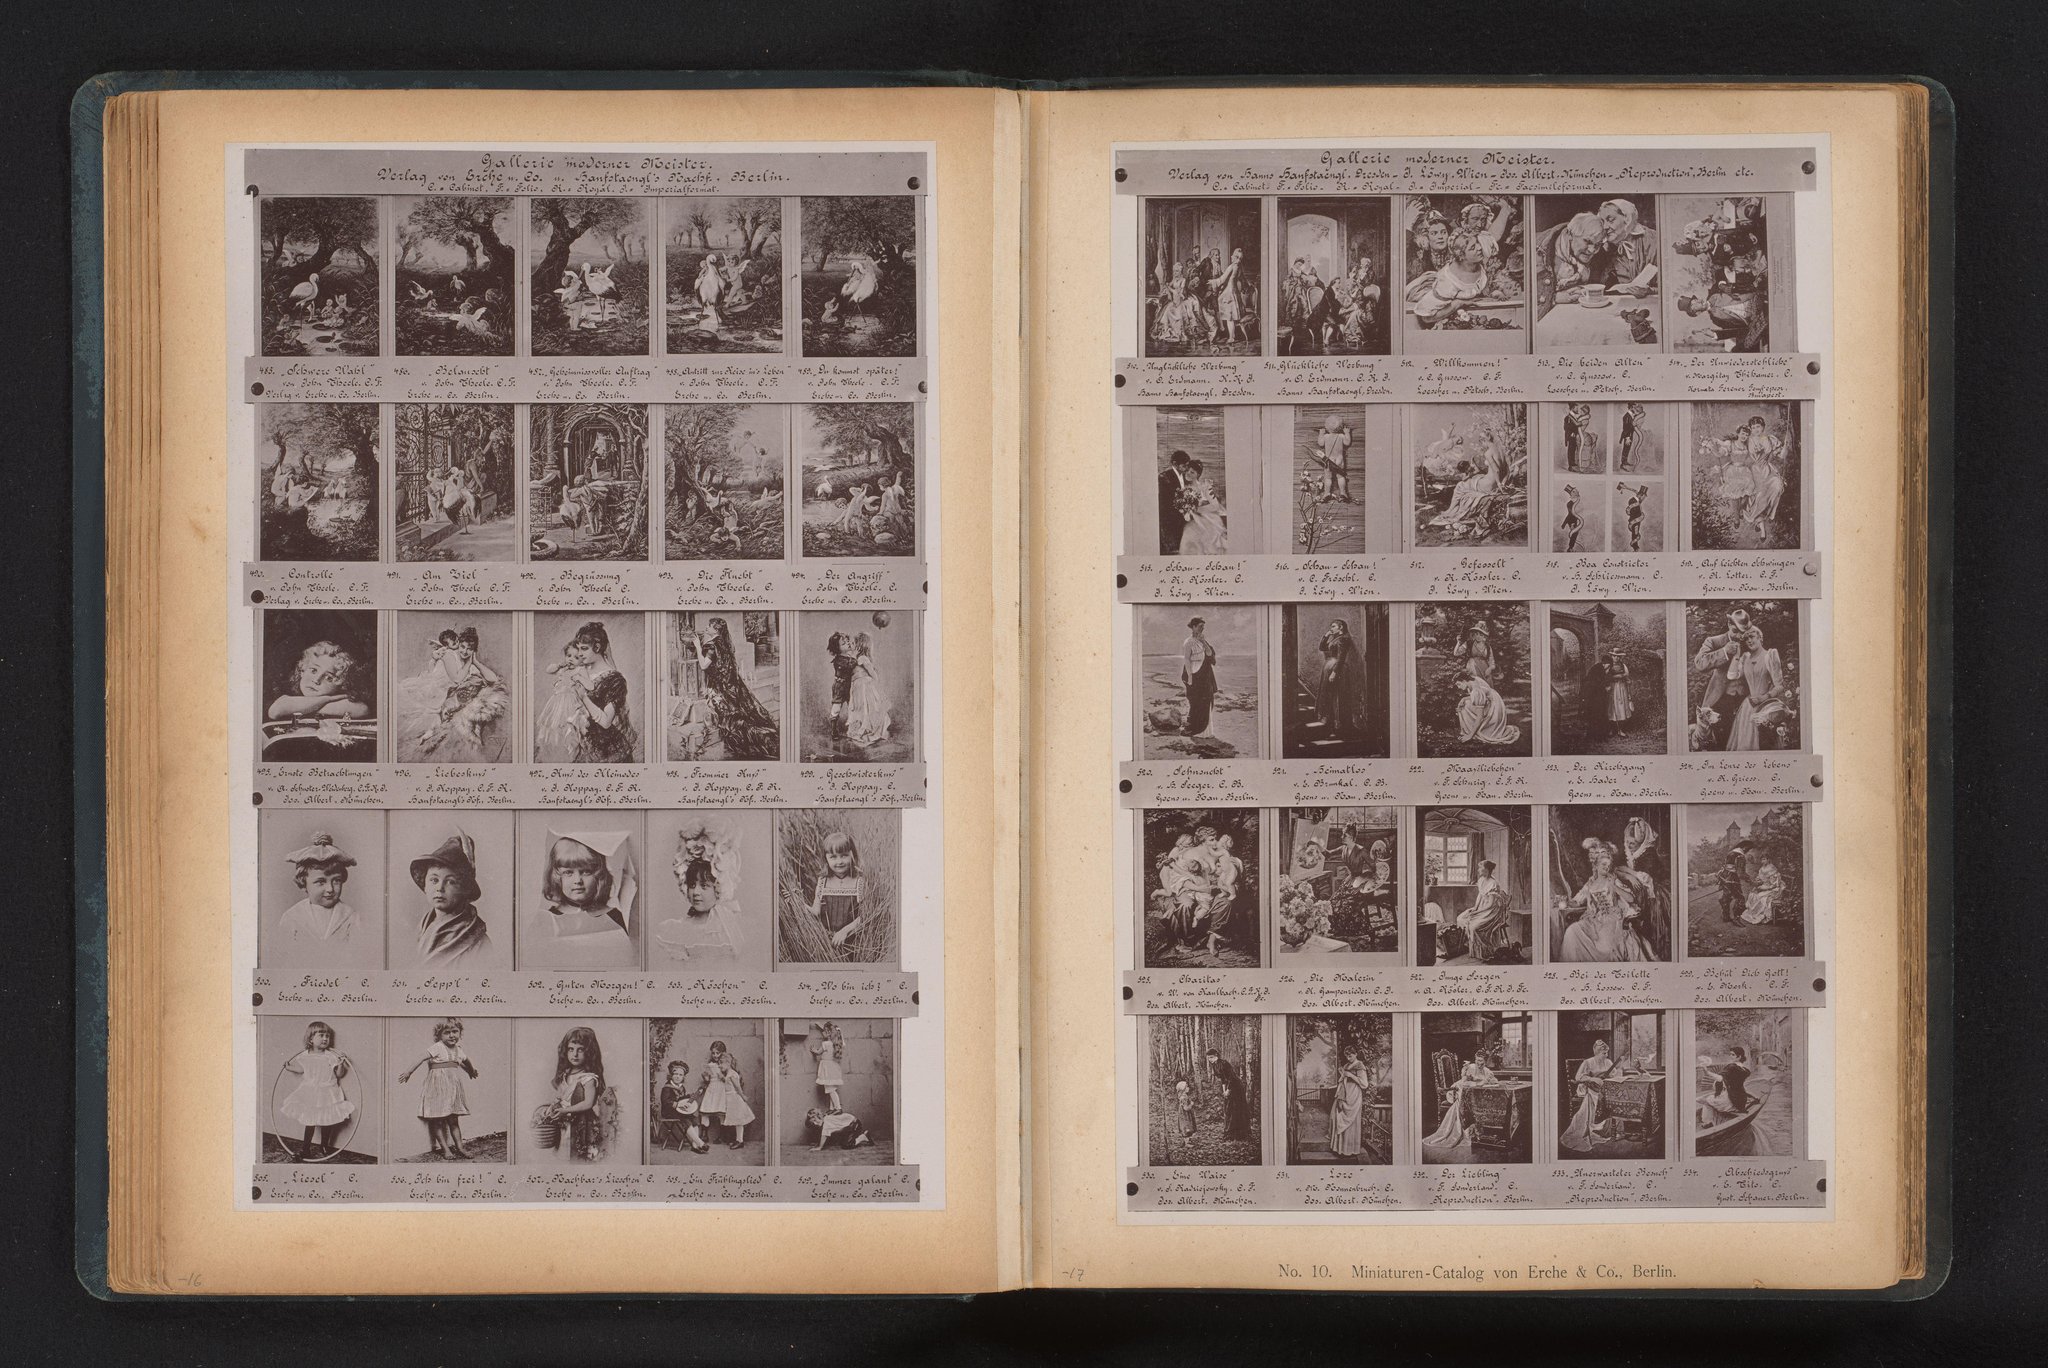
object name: page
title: Fotoreproducties van 25 geschilderde taferelen met engelen en kinderen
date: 1880-1885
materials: paper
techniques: photograph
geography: berlin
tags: child, angels